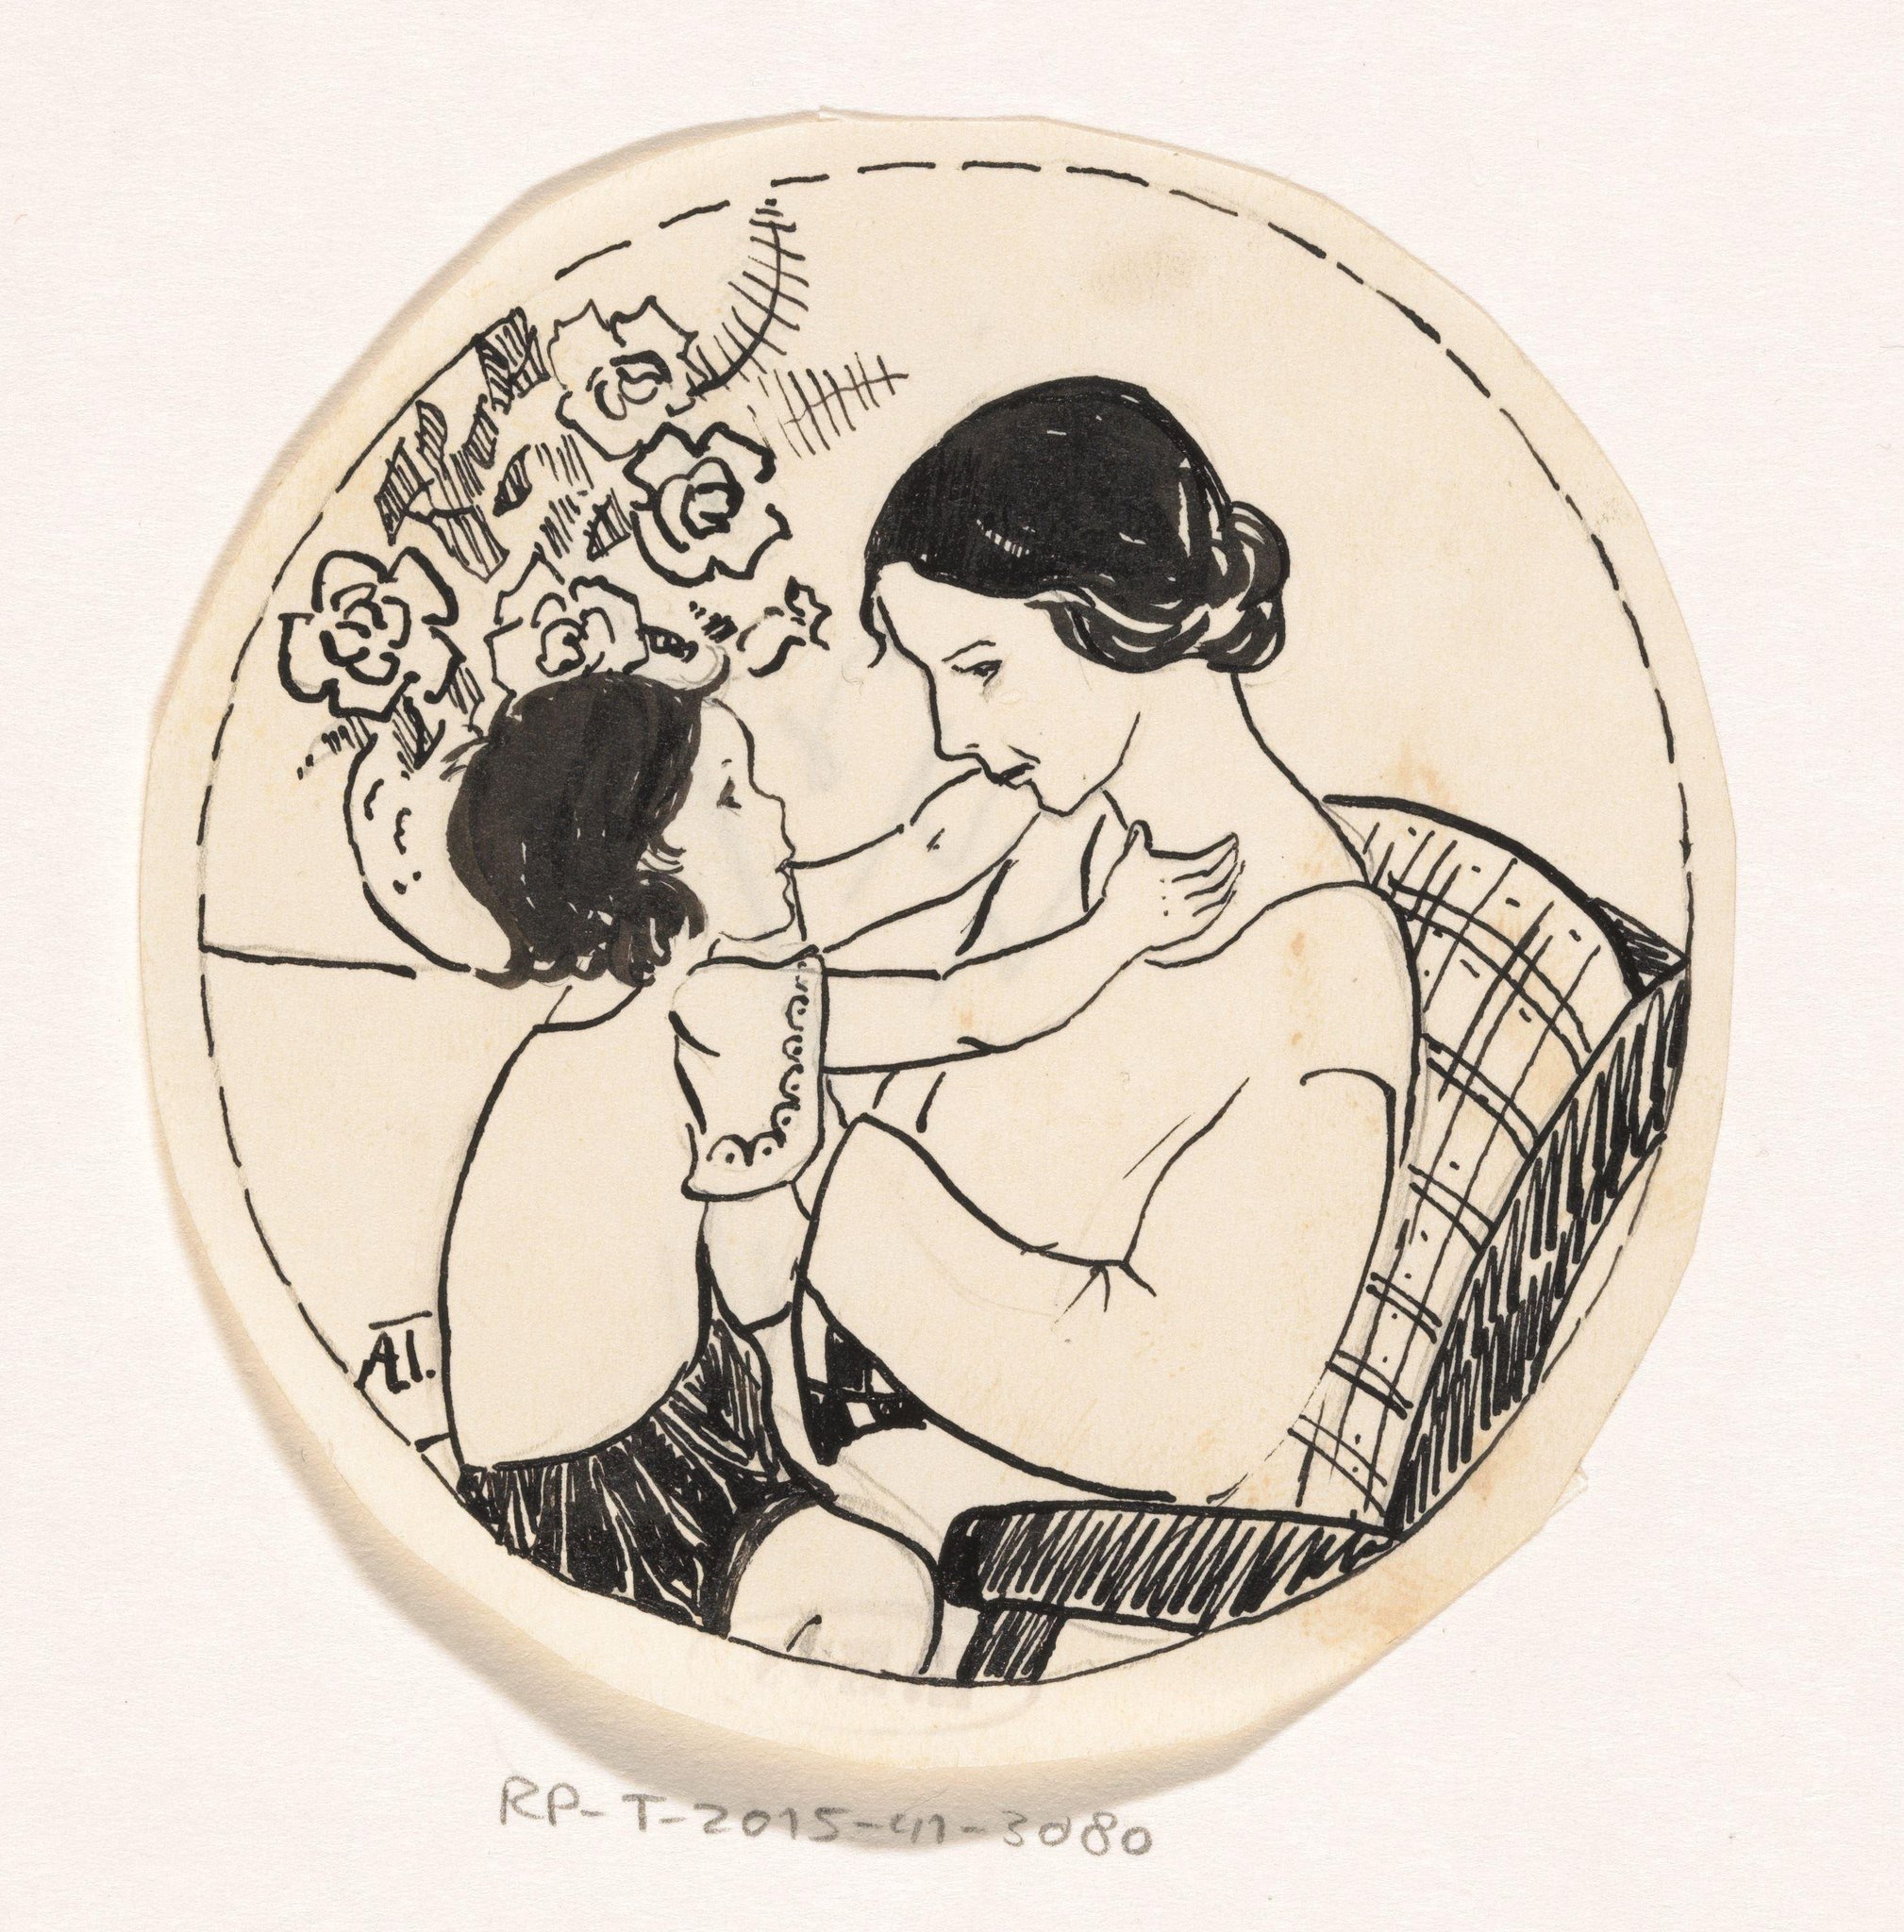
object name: drawing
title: Meisje op moeders schoot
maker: a. tinbergen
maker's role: draughtsman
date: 1925-1935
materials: ink, paper, pencil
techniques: pen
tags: armchair, seat, sitting in someone's lap - aa - female human figure, mother and daughter(s) (family group)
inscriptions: monogram: ‘AT.’, :, collector's mark: Lugt 2228a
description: Een vrouw zit in een leunstoel. Een meisje zit op haar schoot en steekt haar armen uit om haar te omhelzen.